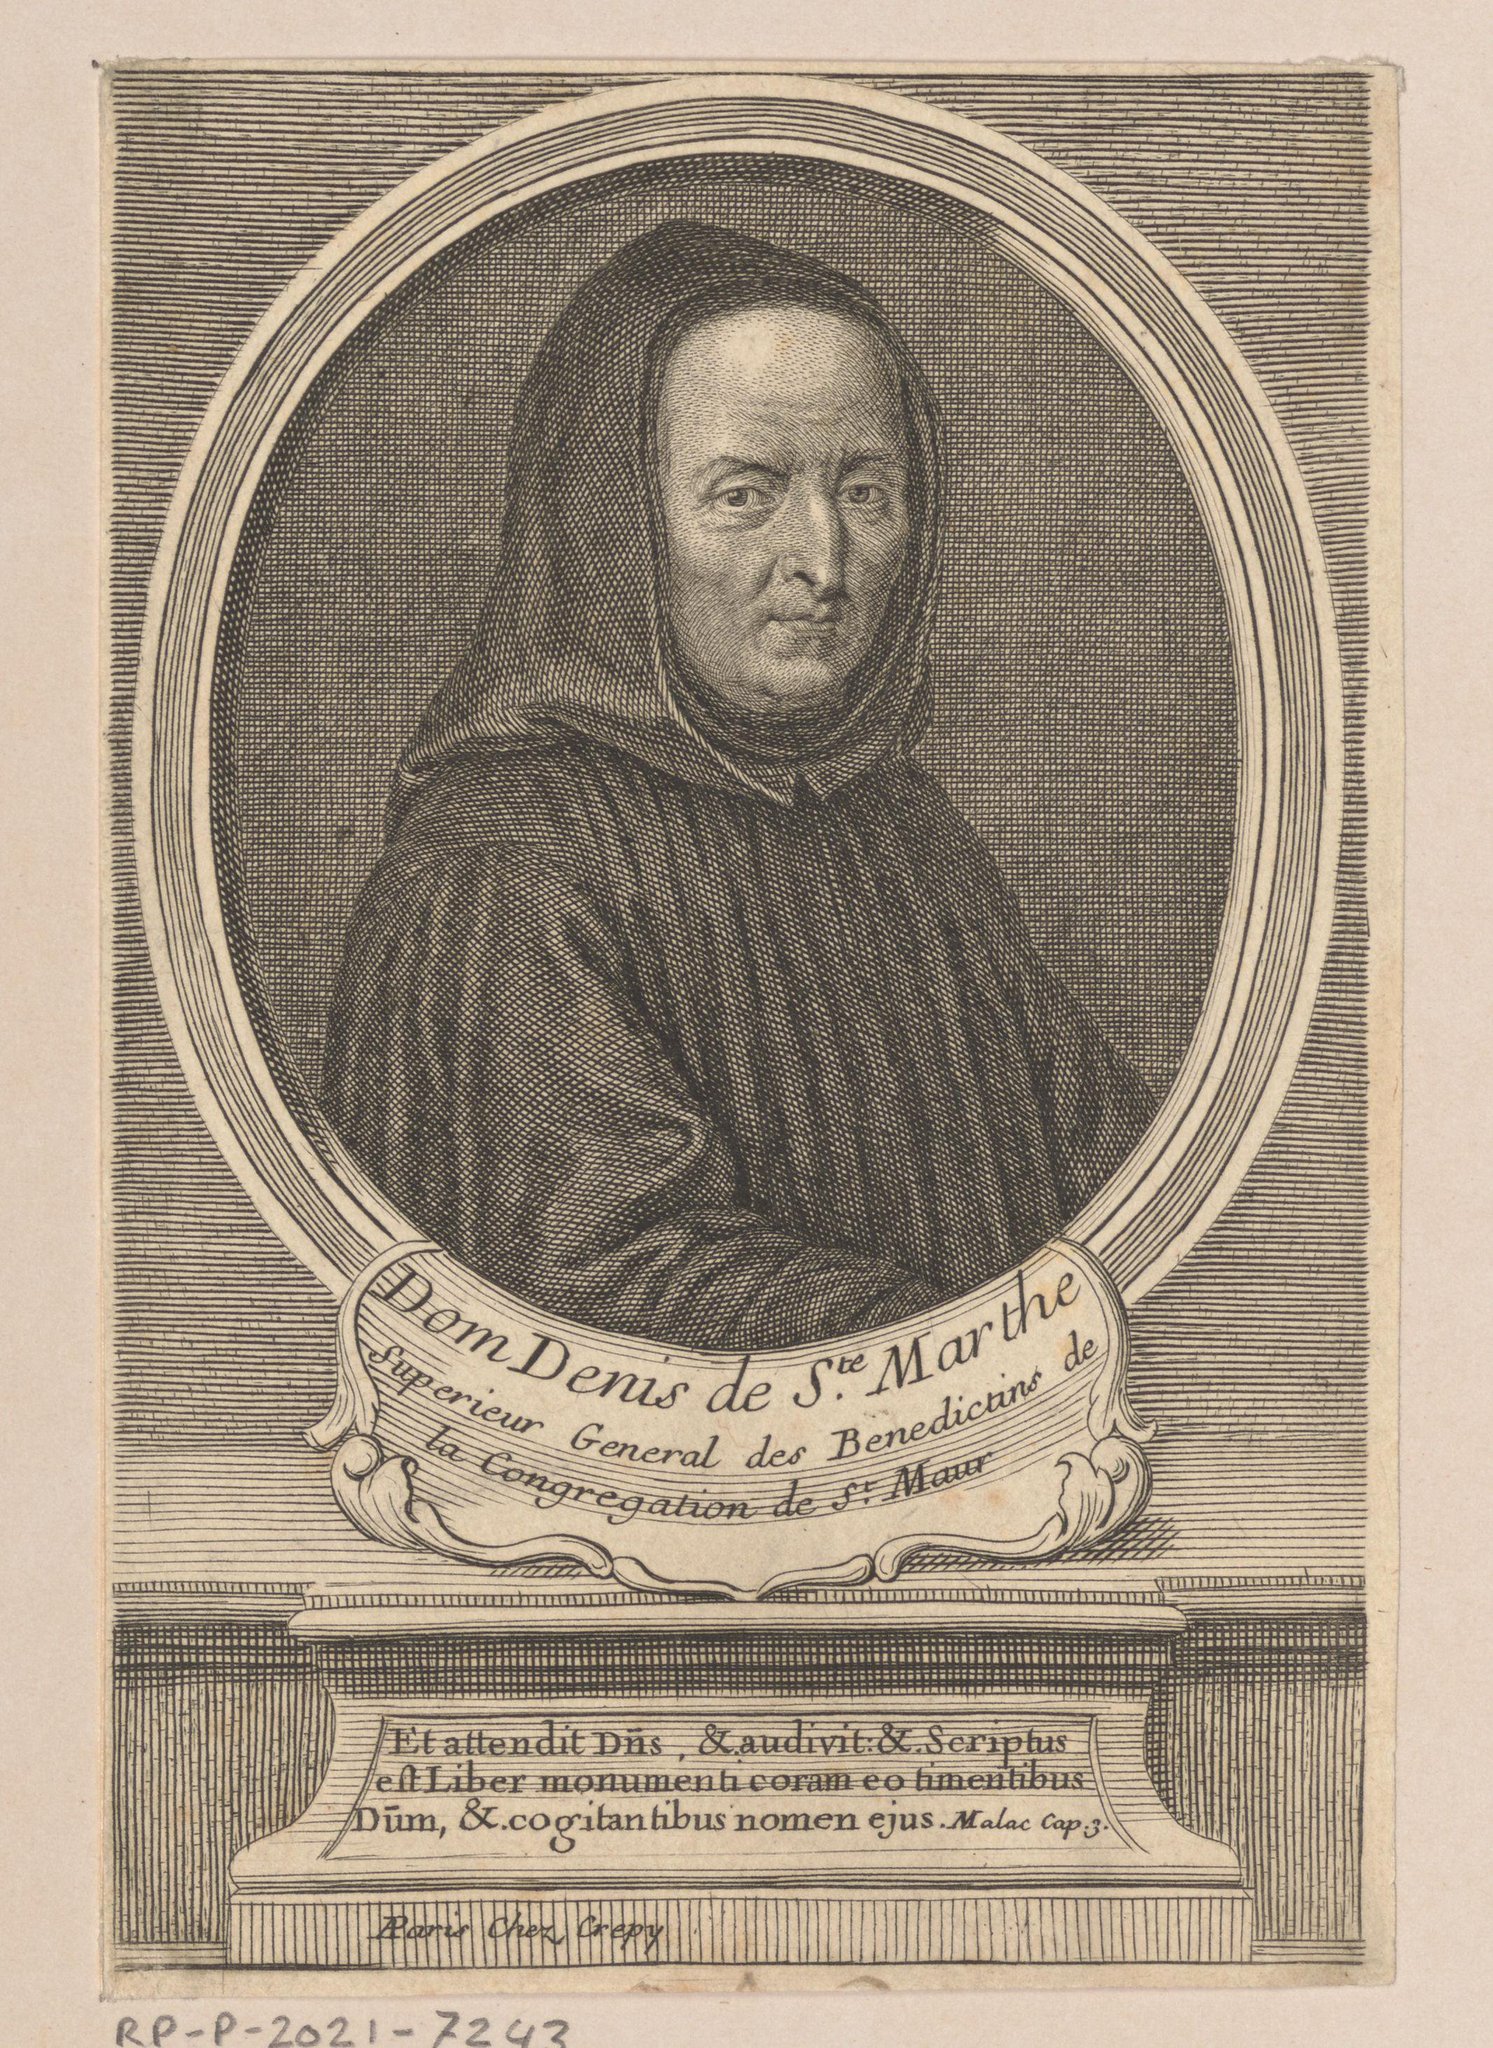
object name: print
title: Portret van Denis de Sainte-Marthe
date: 1670-1739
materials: paper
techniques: engraving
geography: paris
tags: paris, historical persons, monk(s), friar(s)